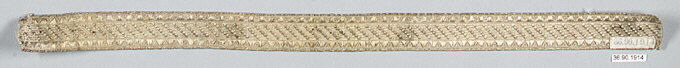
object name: galloon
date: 1801-1900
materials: metal thread